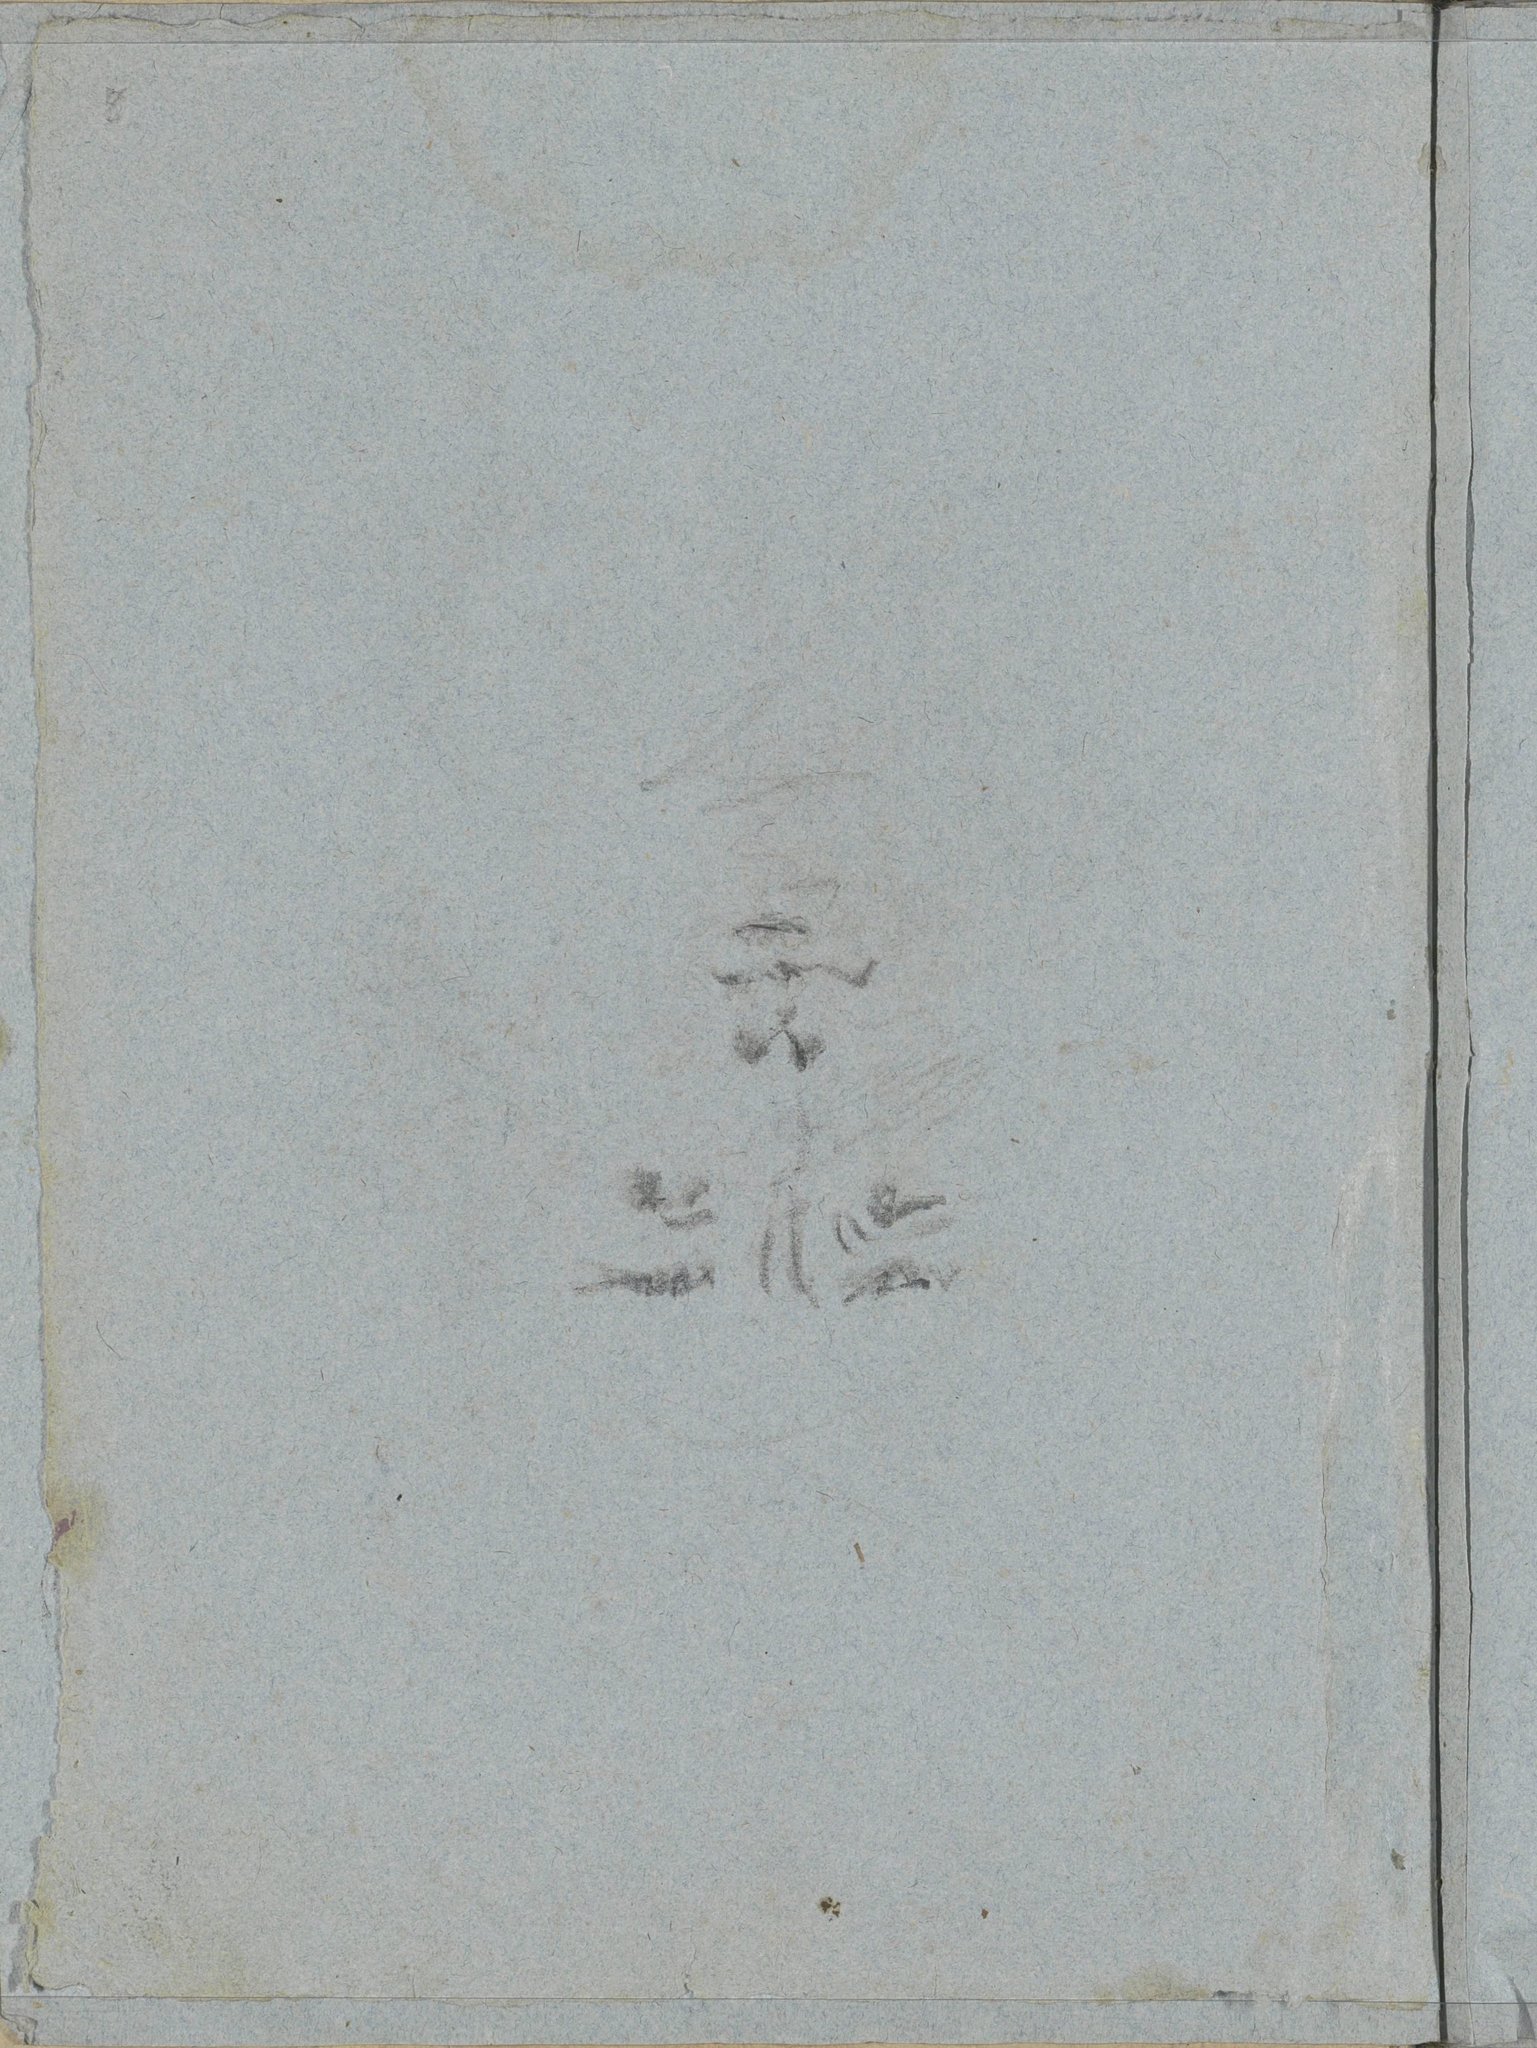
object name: sketchbook leaf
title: Fronsend gezicht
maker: lorenzo baldissera tiepolo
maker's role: draughtsman, print maker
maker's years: 1736-1776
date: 1751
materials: chalk, paper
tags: face, frowned eyebrows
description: Bladzijde 8 uit een schetsboek met 158 bladzijden.